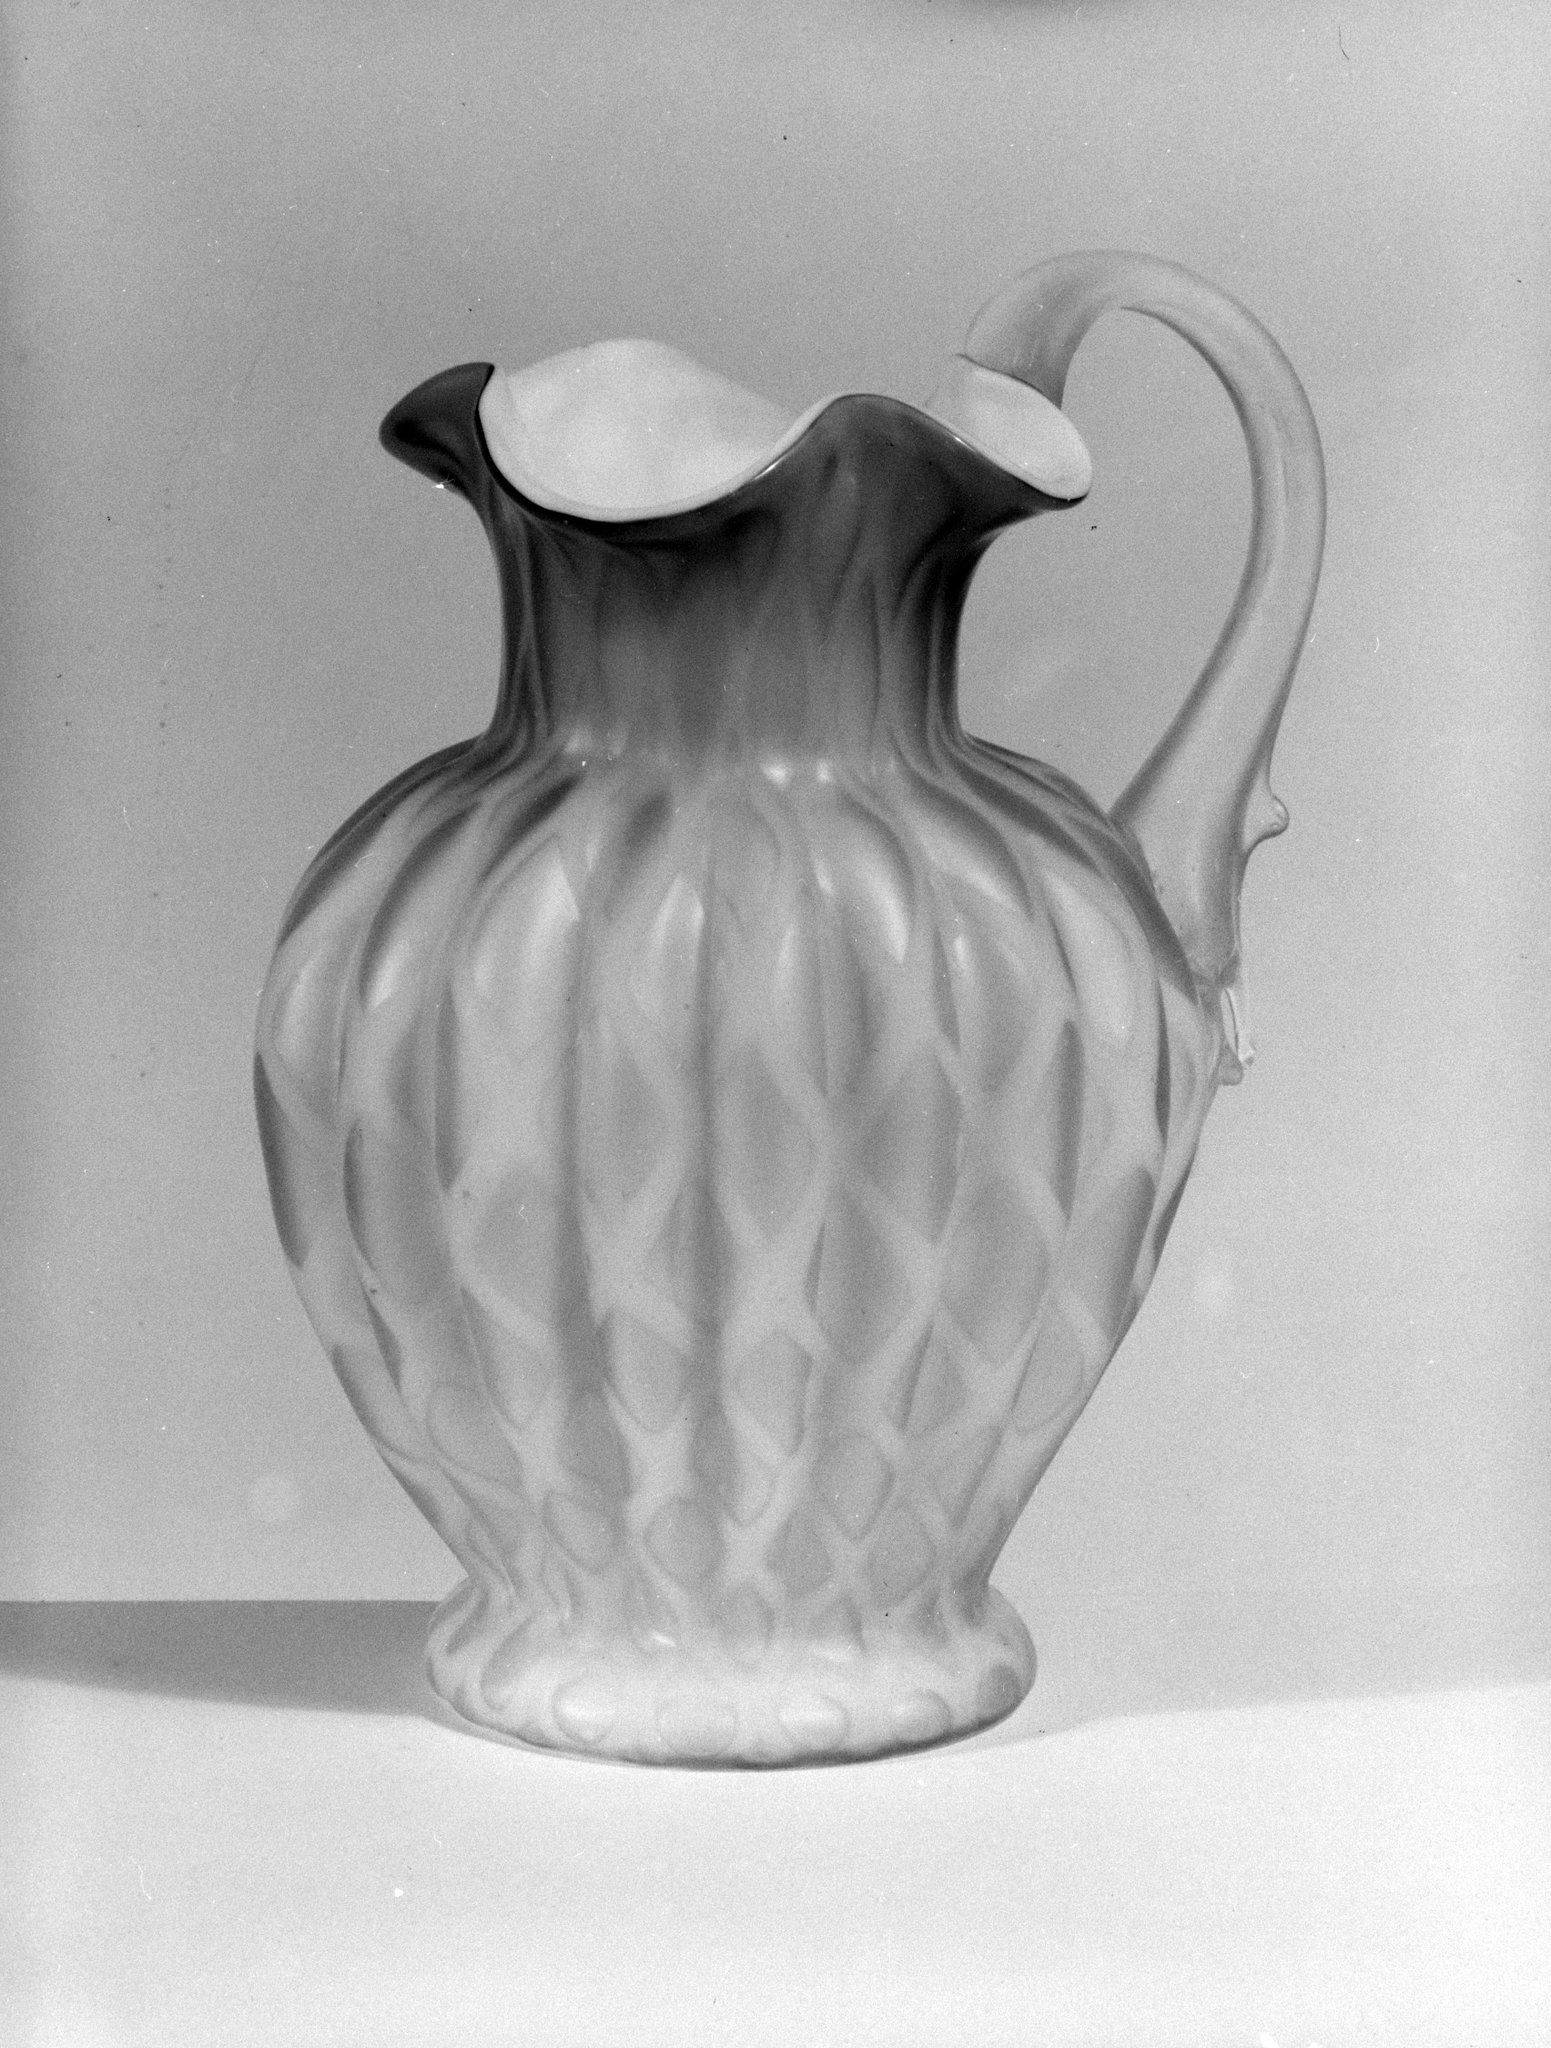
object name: pitcher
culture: american or british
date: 1885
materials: glass, textile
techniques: glassblowing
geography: england